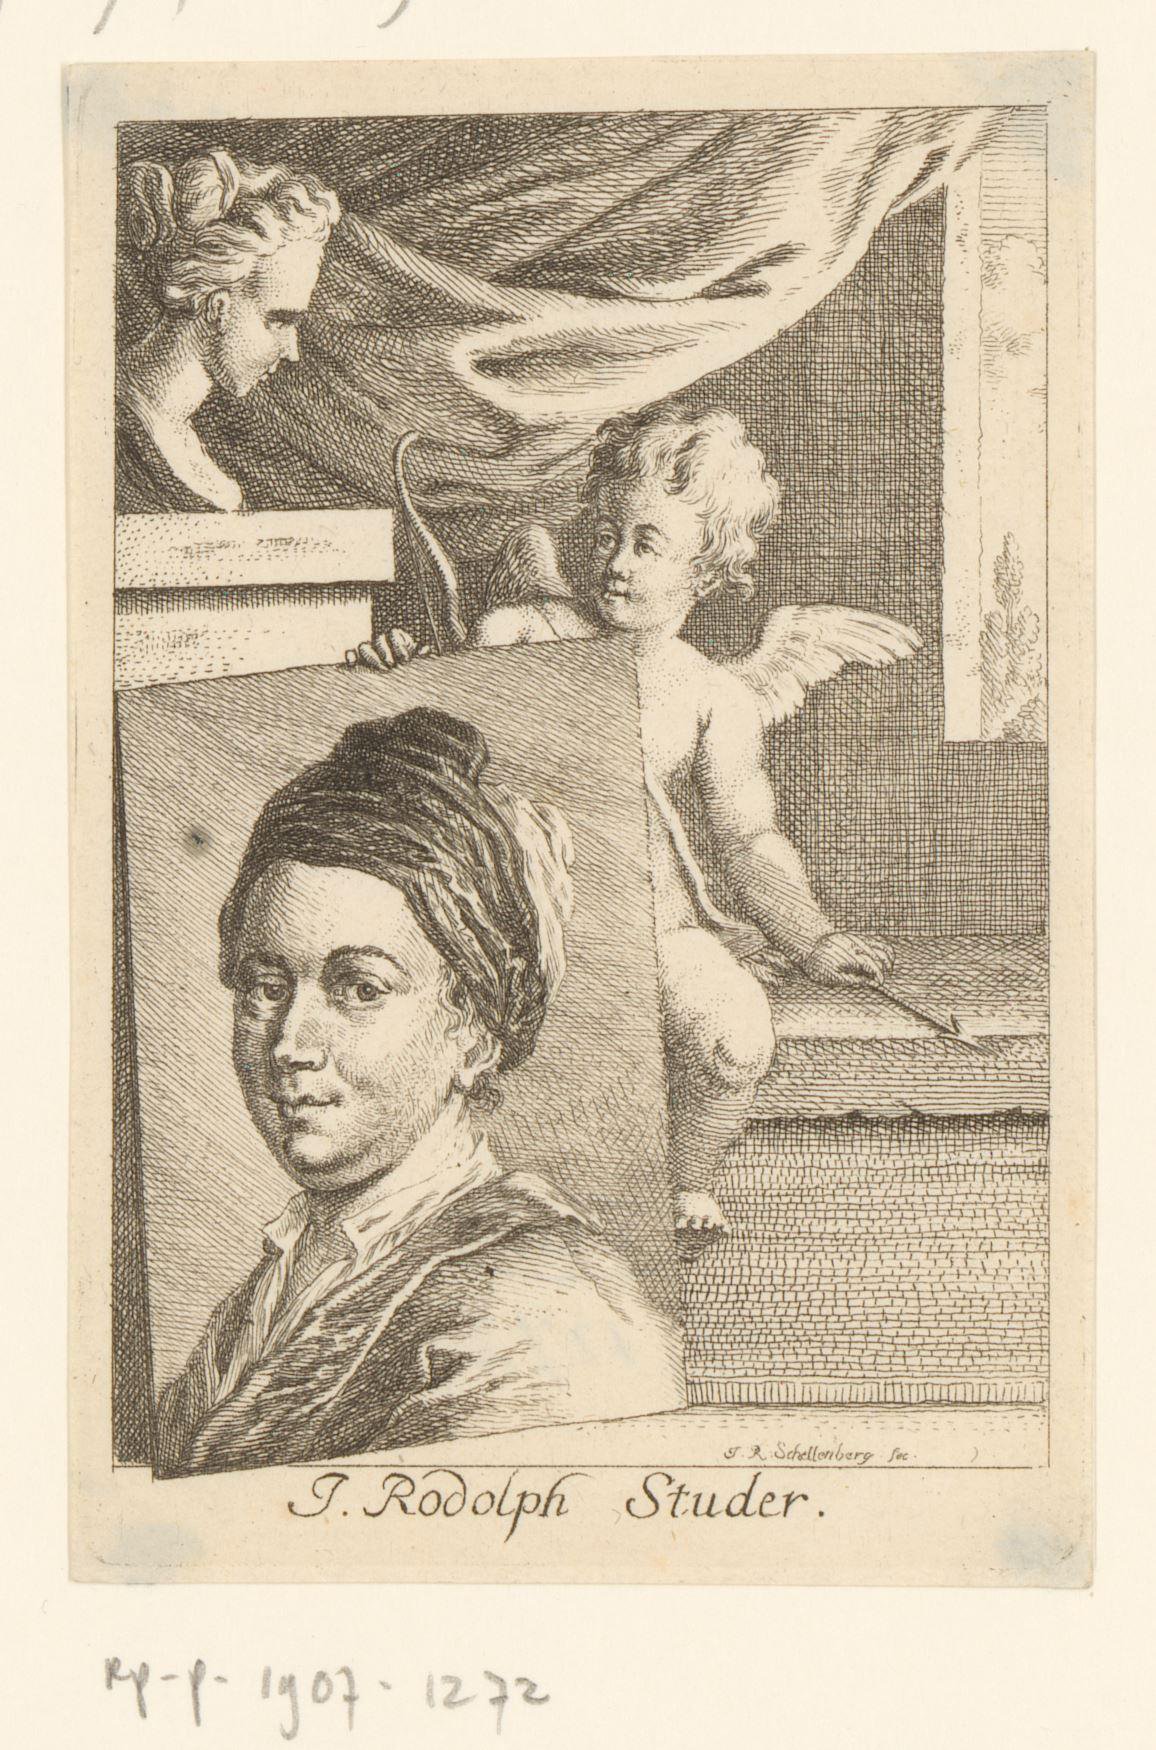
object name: print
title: Portret van Johann Rudolf Studer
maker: johann rudolph schellenberg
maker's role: print maker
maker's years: 1740-1806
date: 1750-1806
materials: paper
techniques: etching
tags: amsterdam, painter, artist, portrait, self-portrait of painter, piece of sculpture, reproduction of a piece of sculpture, cupids: 'amores', 'amoretti', 'putti'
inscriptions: collector's mark: Lugt 2228